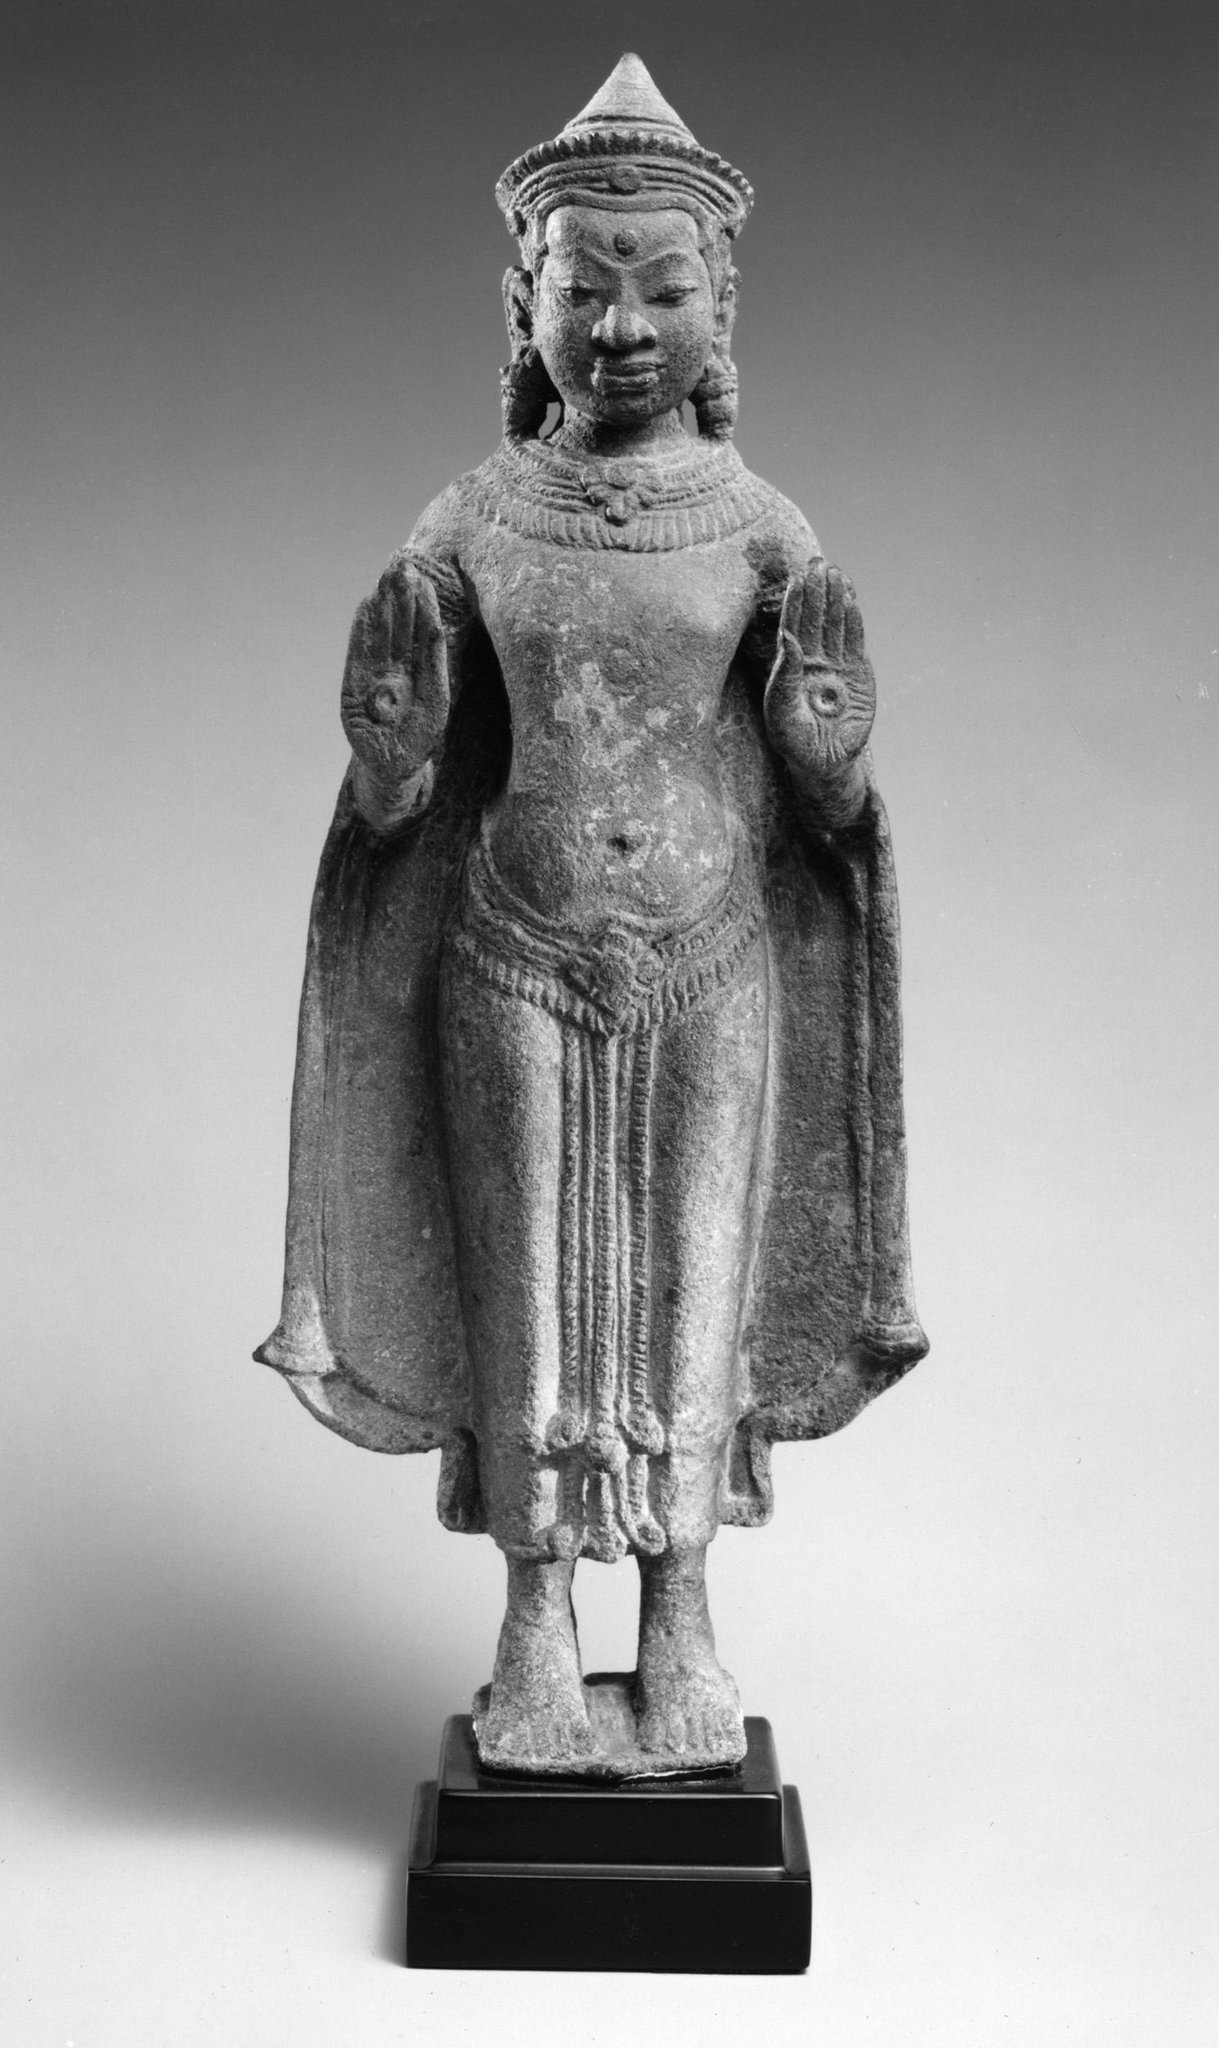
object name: figure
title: Standing Crowned and Jeweled Buddha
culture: thai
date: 1101-1200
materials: bronze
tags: buddhism,buddha